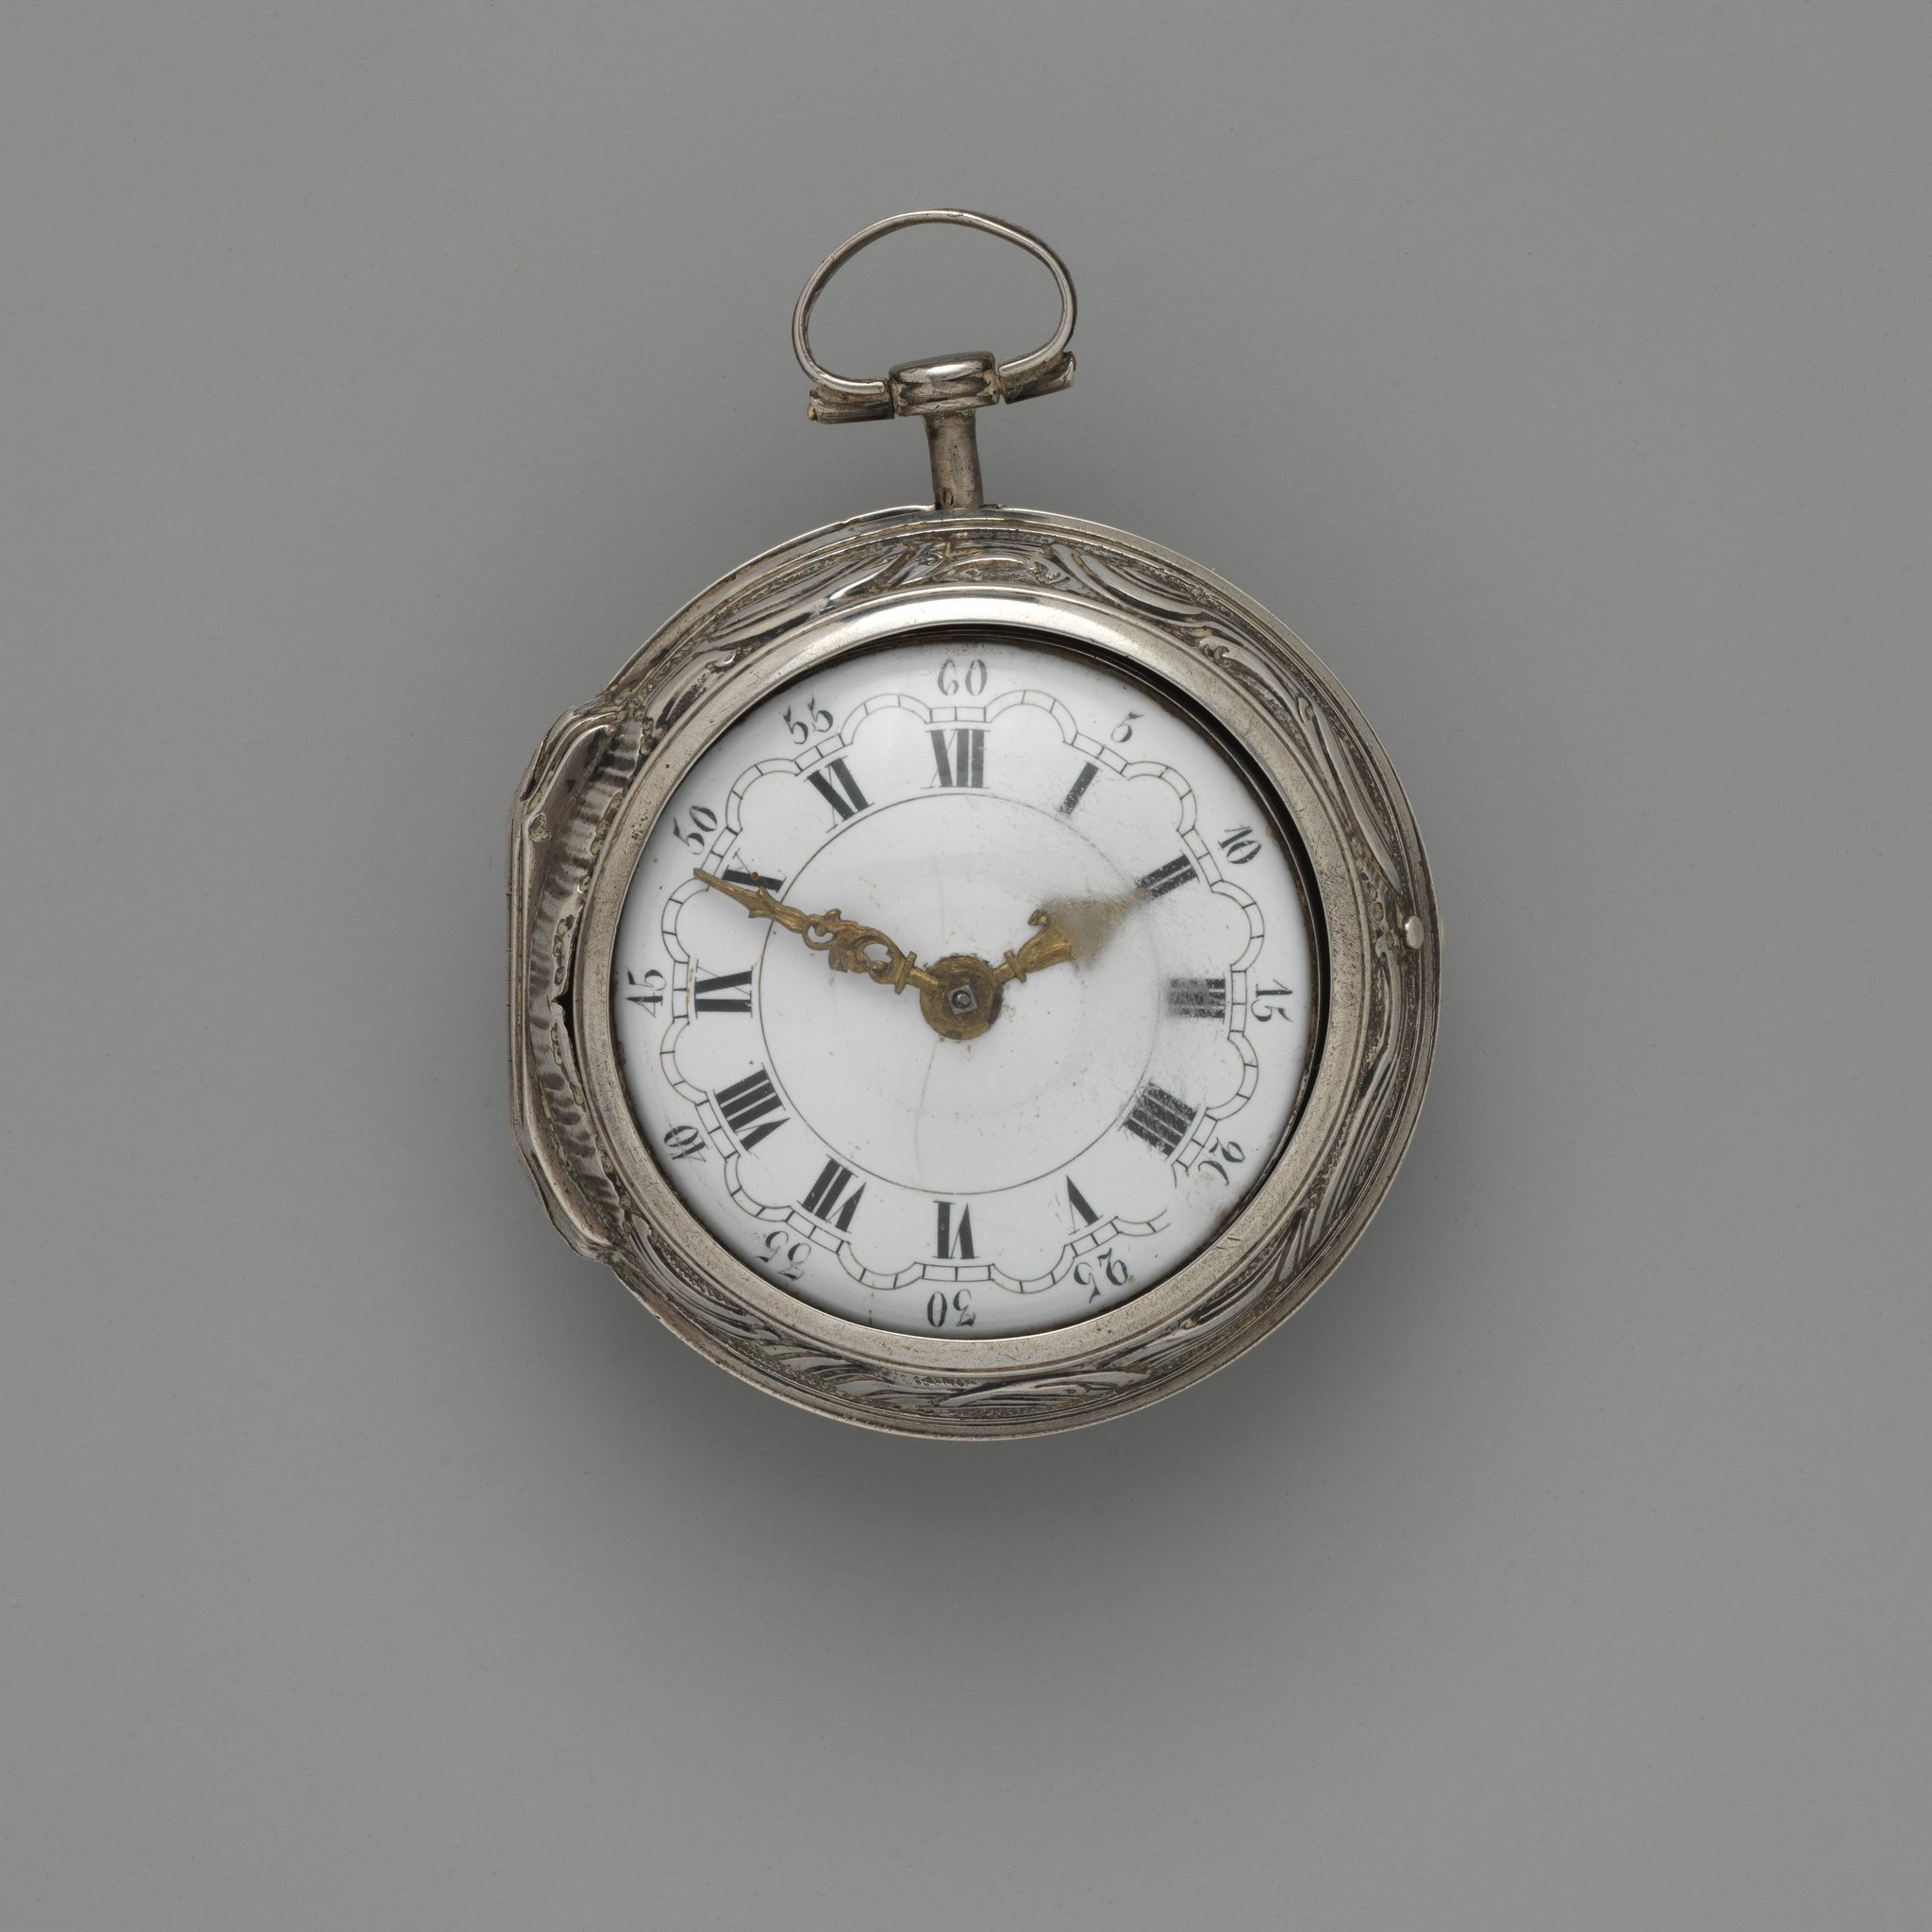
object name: watch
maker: j. tarts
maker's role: maker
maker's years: 1755-1790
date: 1781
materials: enamel, silver